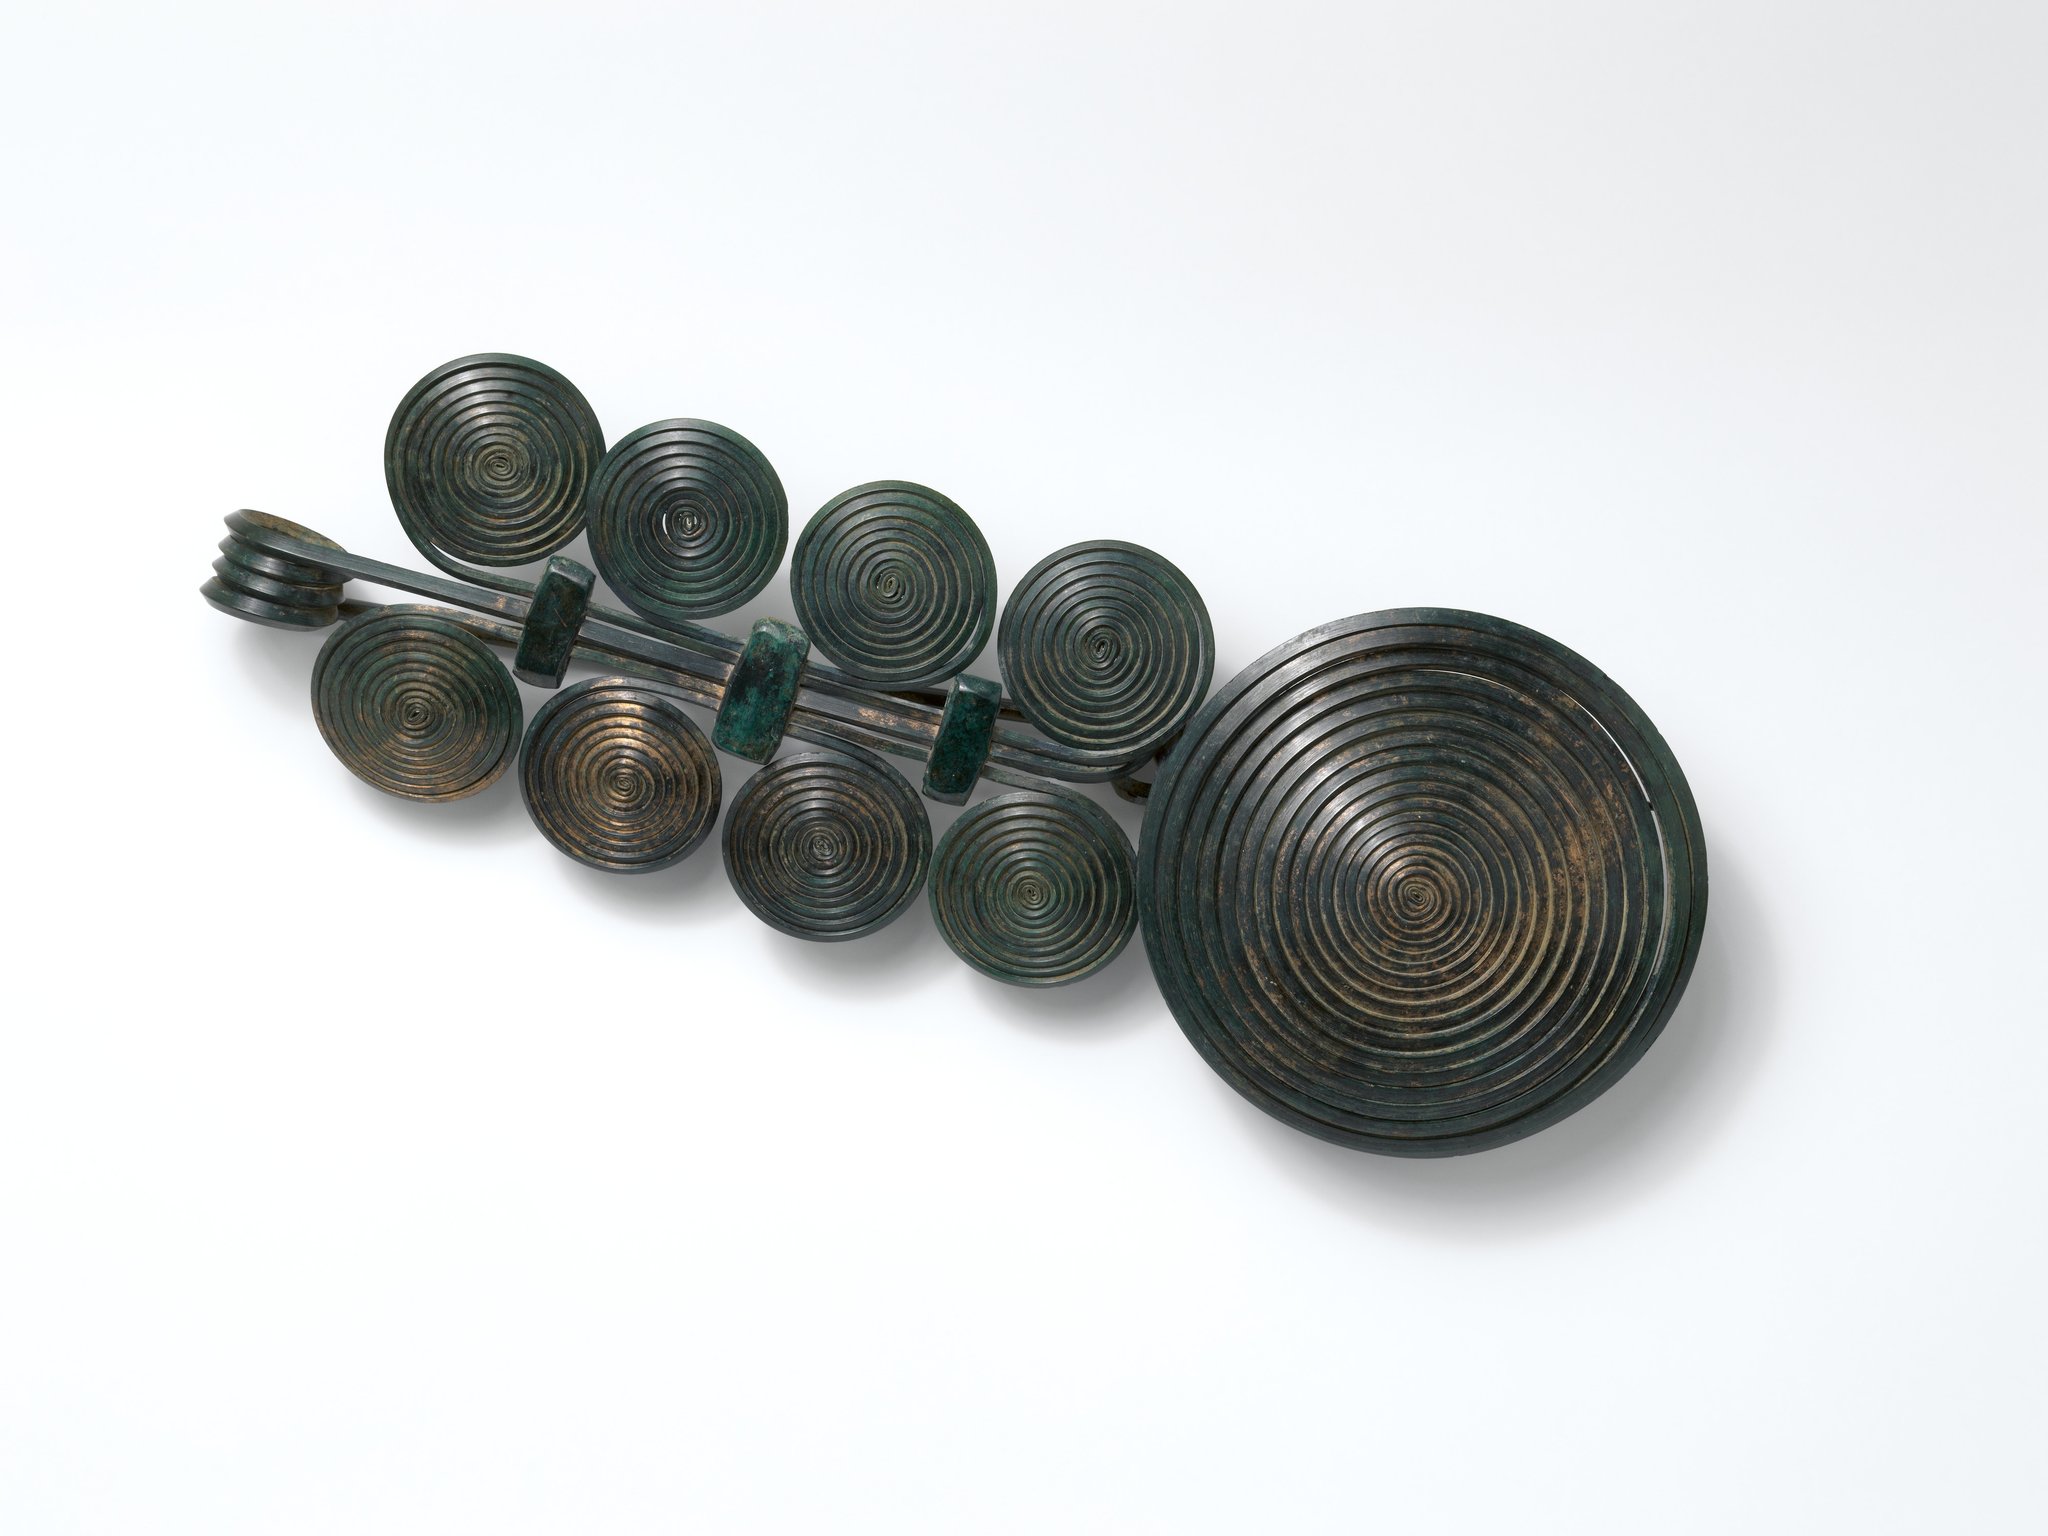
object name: brooch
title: Large Brooch with Spirals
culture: european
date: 1200-800 BCE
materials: bronze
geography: carpathian basin